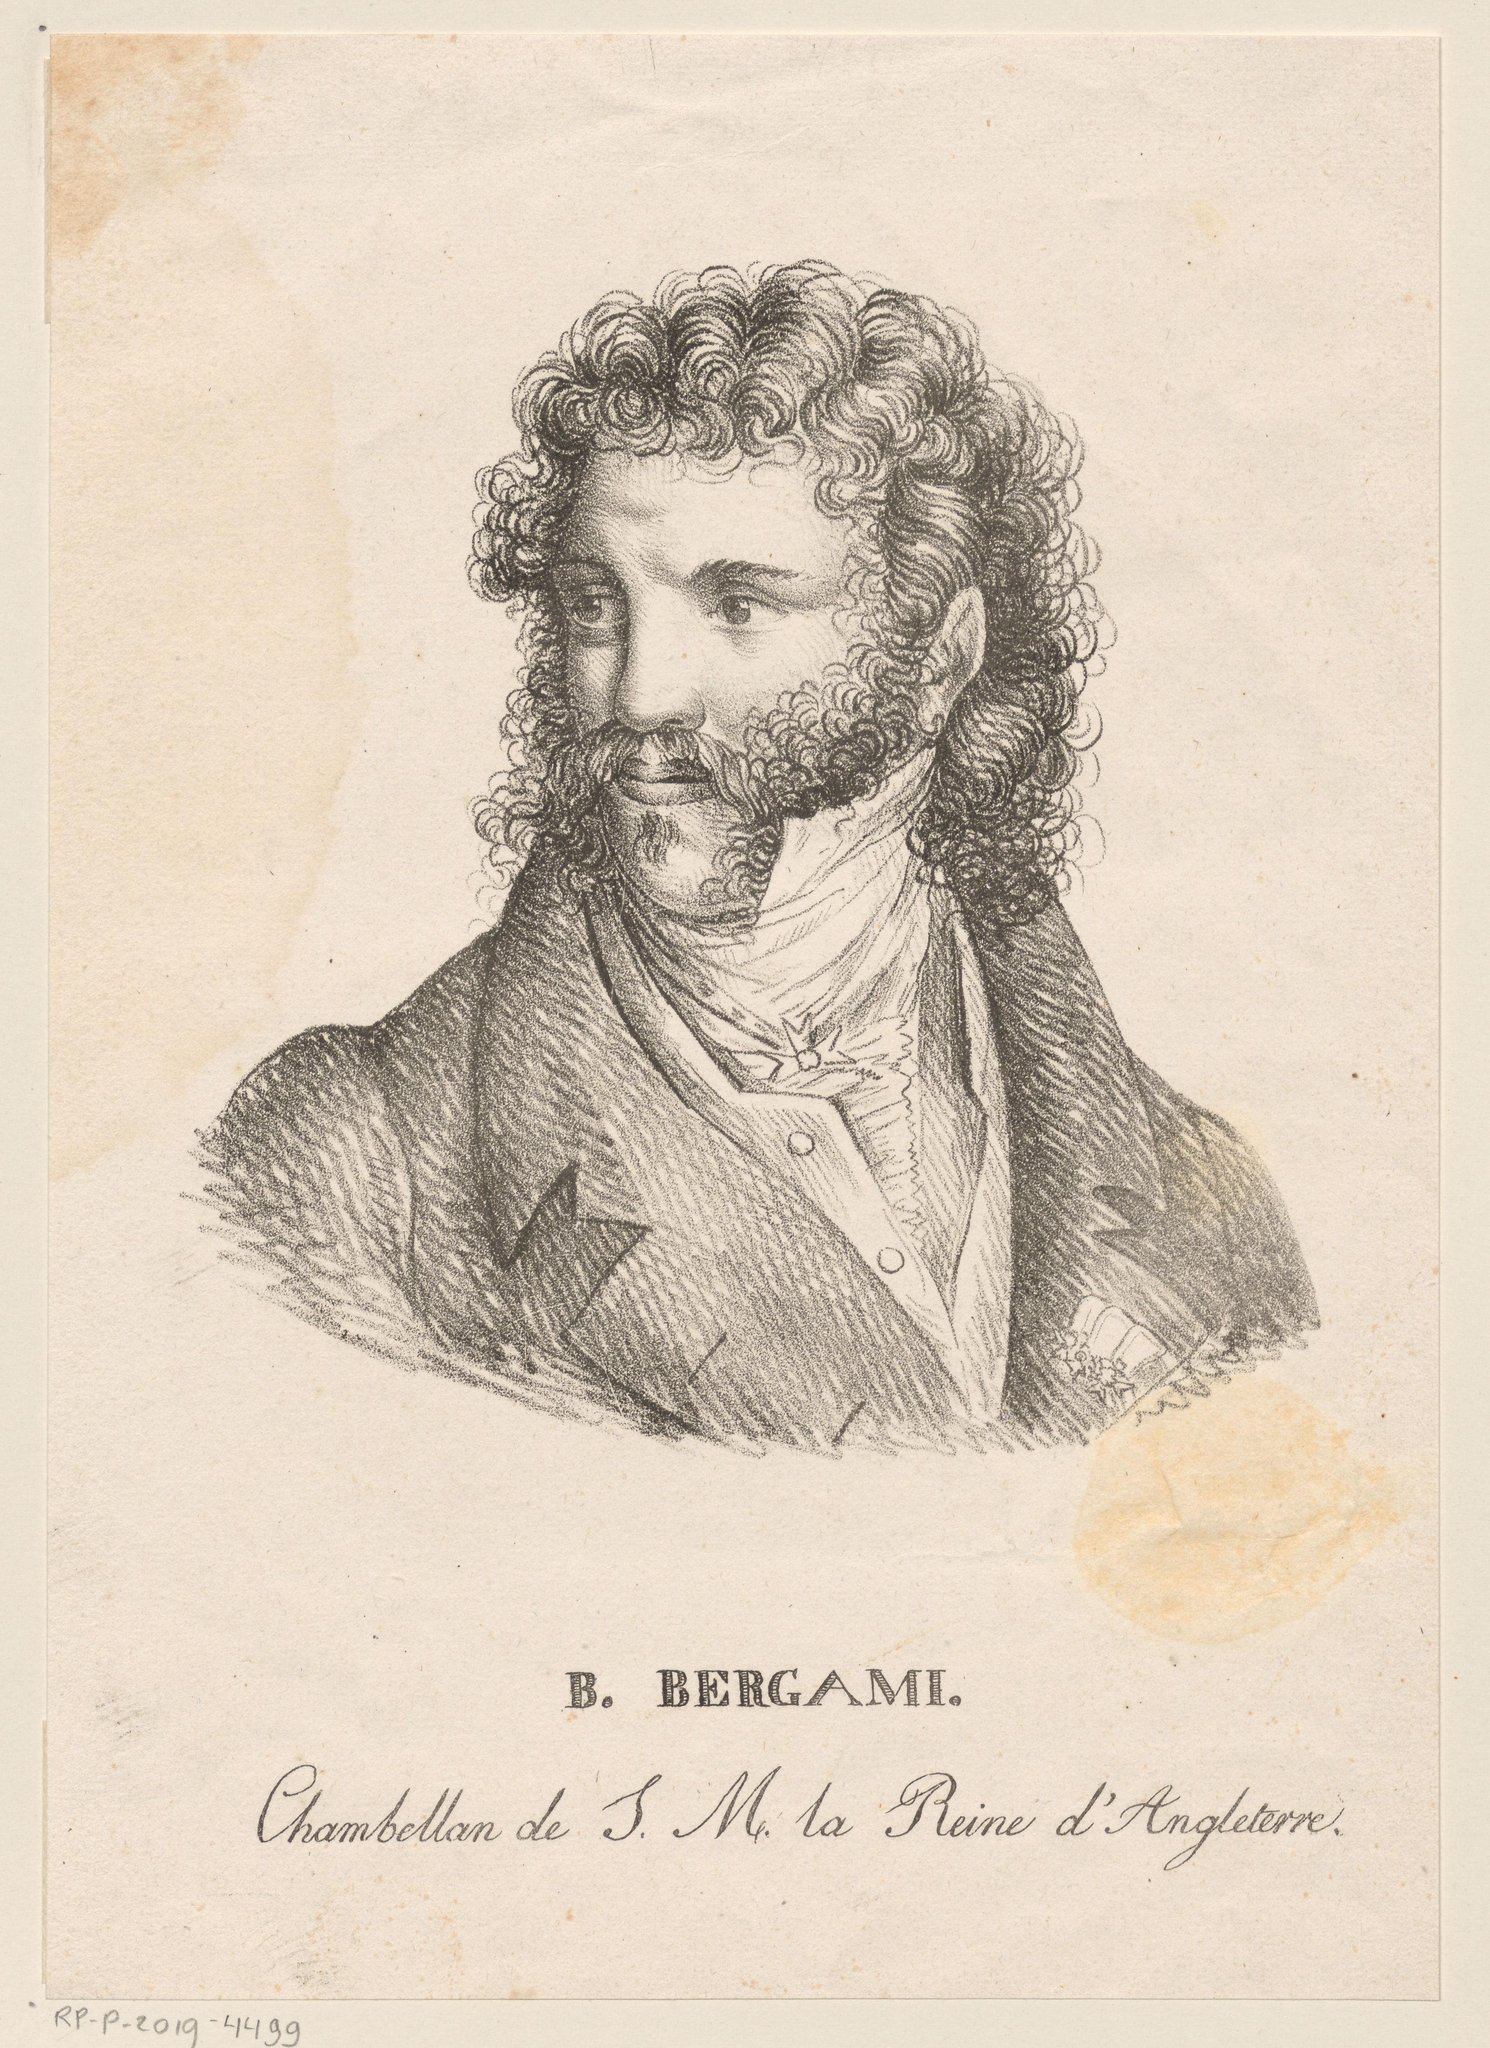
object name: print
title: Portret van Bartolomeo Bergami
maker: Anonymous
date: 1814-1849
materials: paper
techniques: lithograph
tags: earl, historical persons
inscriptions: collector's mark: Lugt 2228